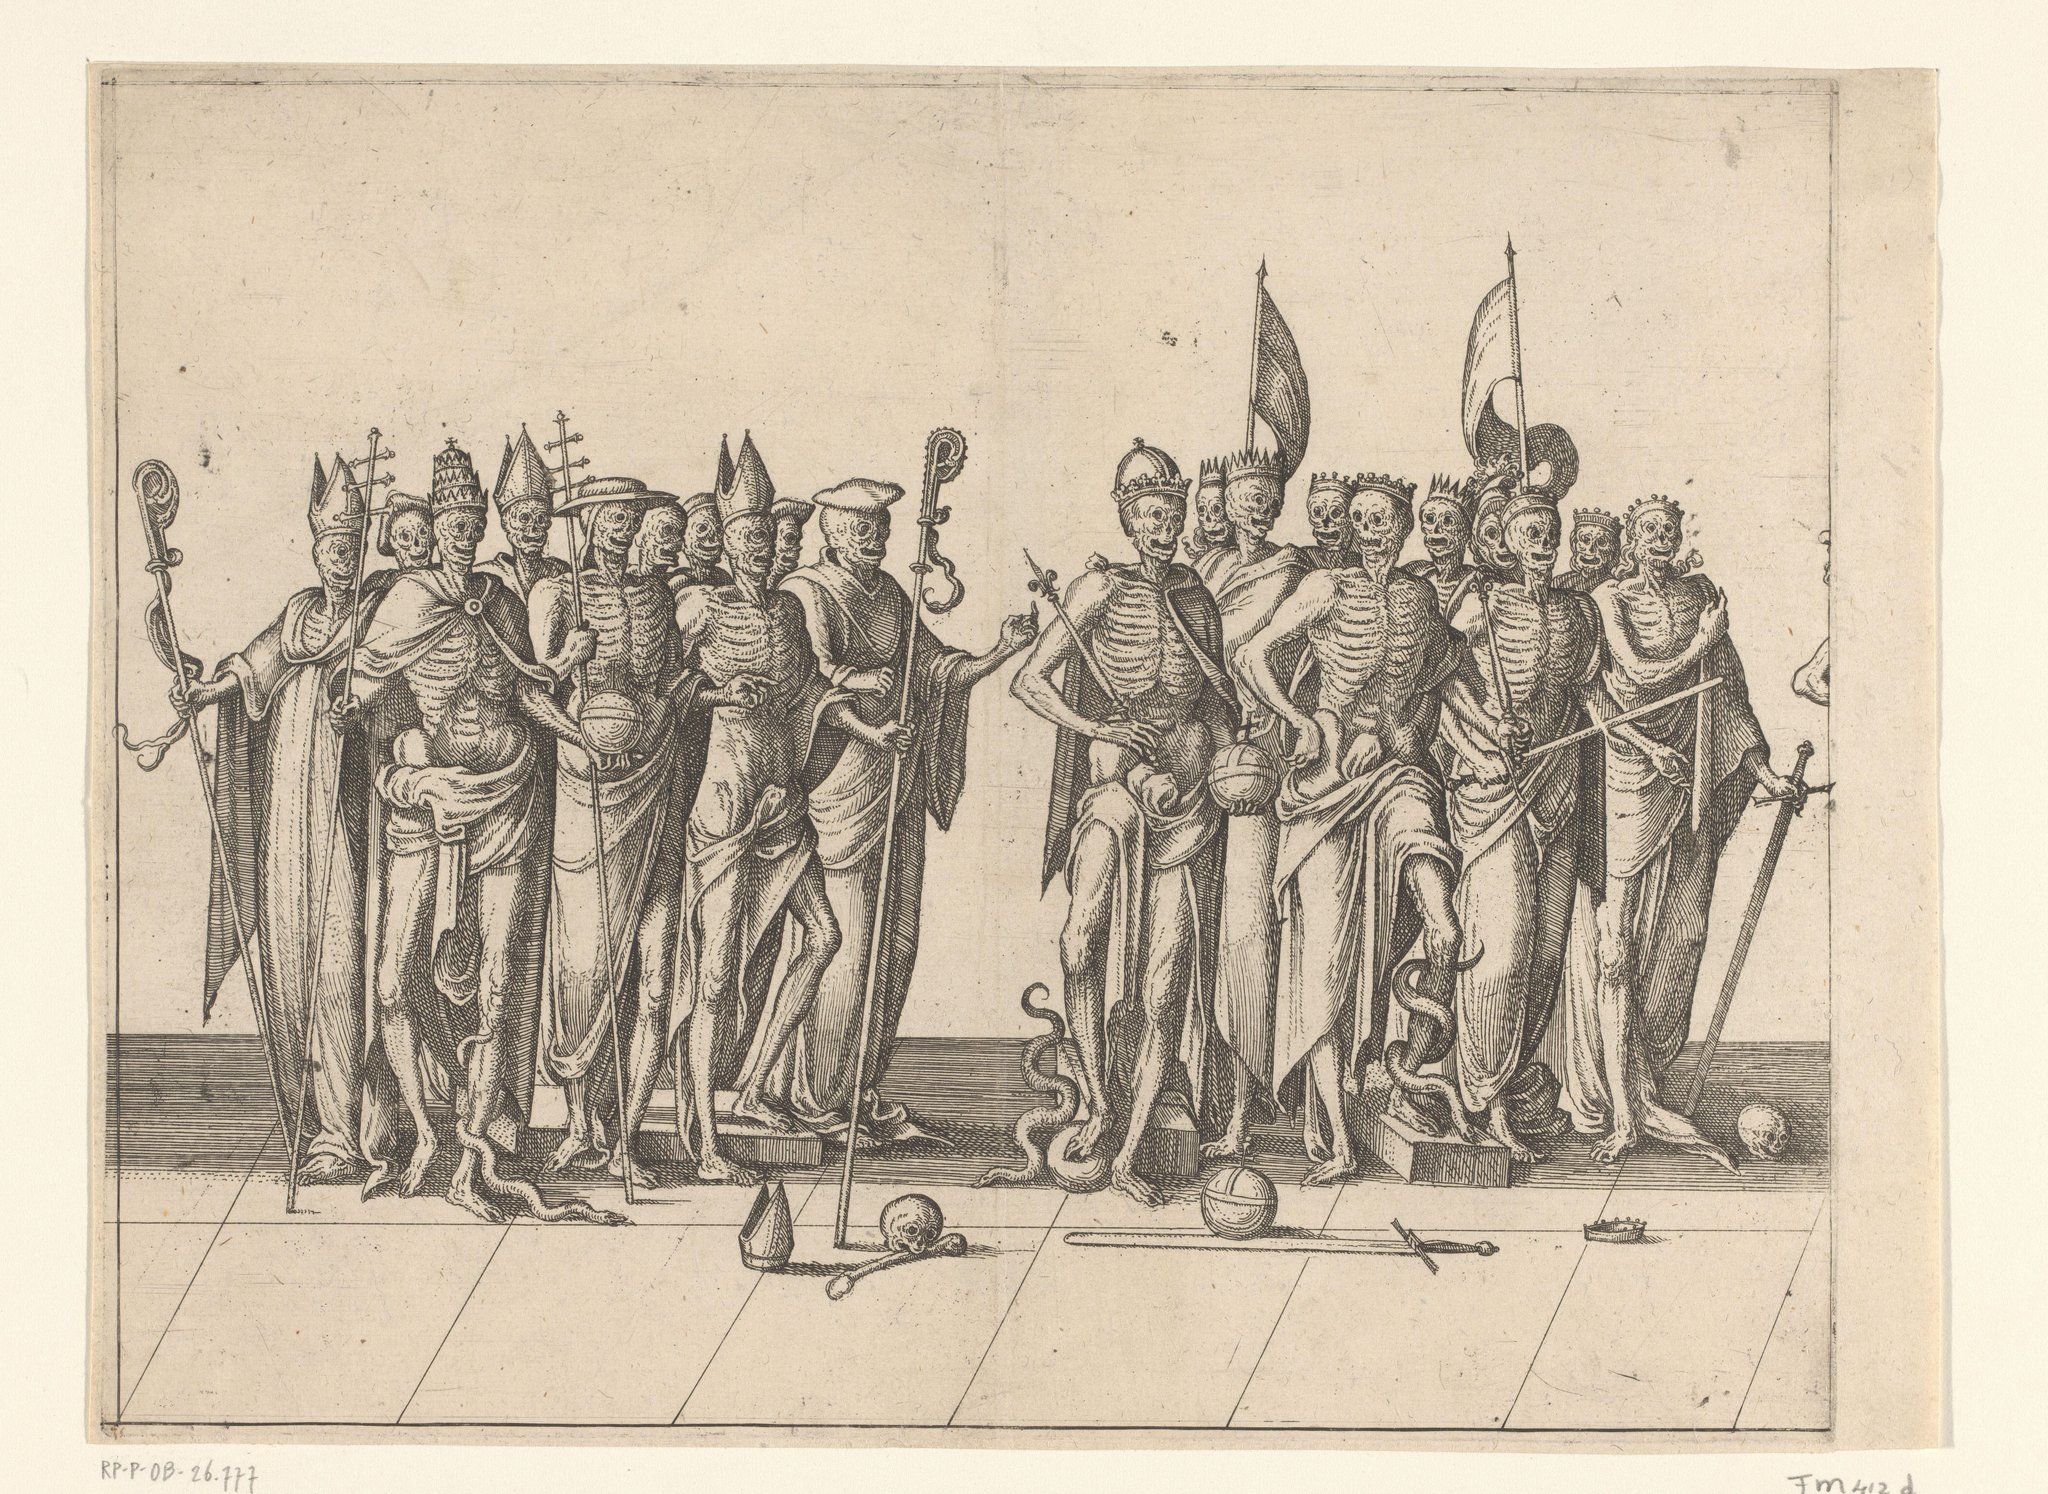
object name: book illustration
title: Dodenprocessie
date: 1558-1619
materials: paper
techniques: etching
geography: the hague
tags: charles v (holy roman emperor and king of spain), dance of death; death together with one or more human beings, cortege, funeral procession, other divisions into classes (~ society), mummy, death's head, skull (symbol of death), brussels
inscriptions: collector's mark: Lugt 2228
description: Dodendans: linkerplaat. Van links naar rechts staan groepen mummies die de geestelijkheid en de koningen voorstellen. Op de grond voor de groepen liggen de symbolen van hun stand. Verspreid over de voorgrond liggen symbolen van vergankelijkheid zoals doodshoofden en slangen.